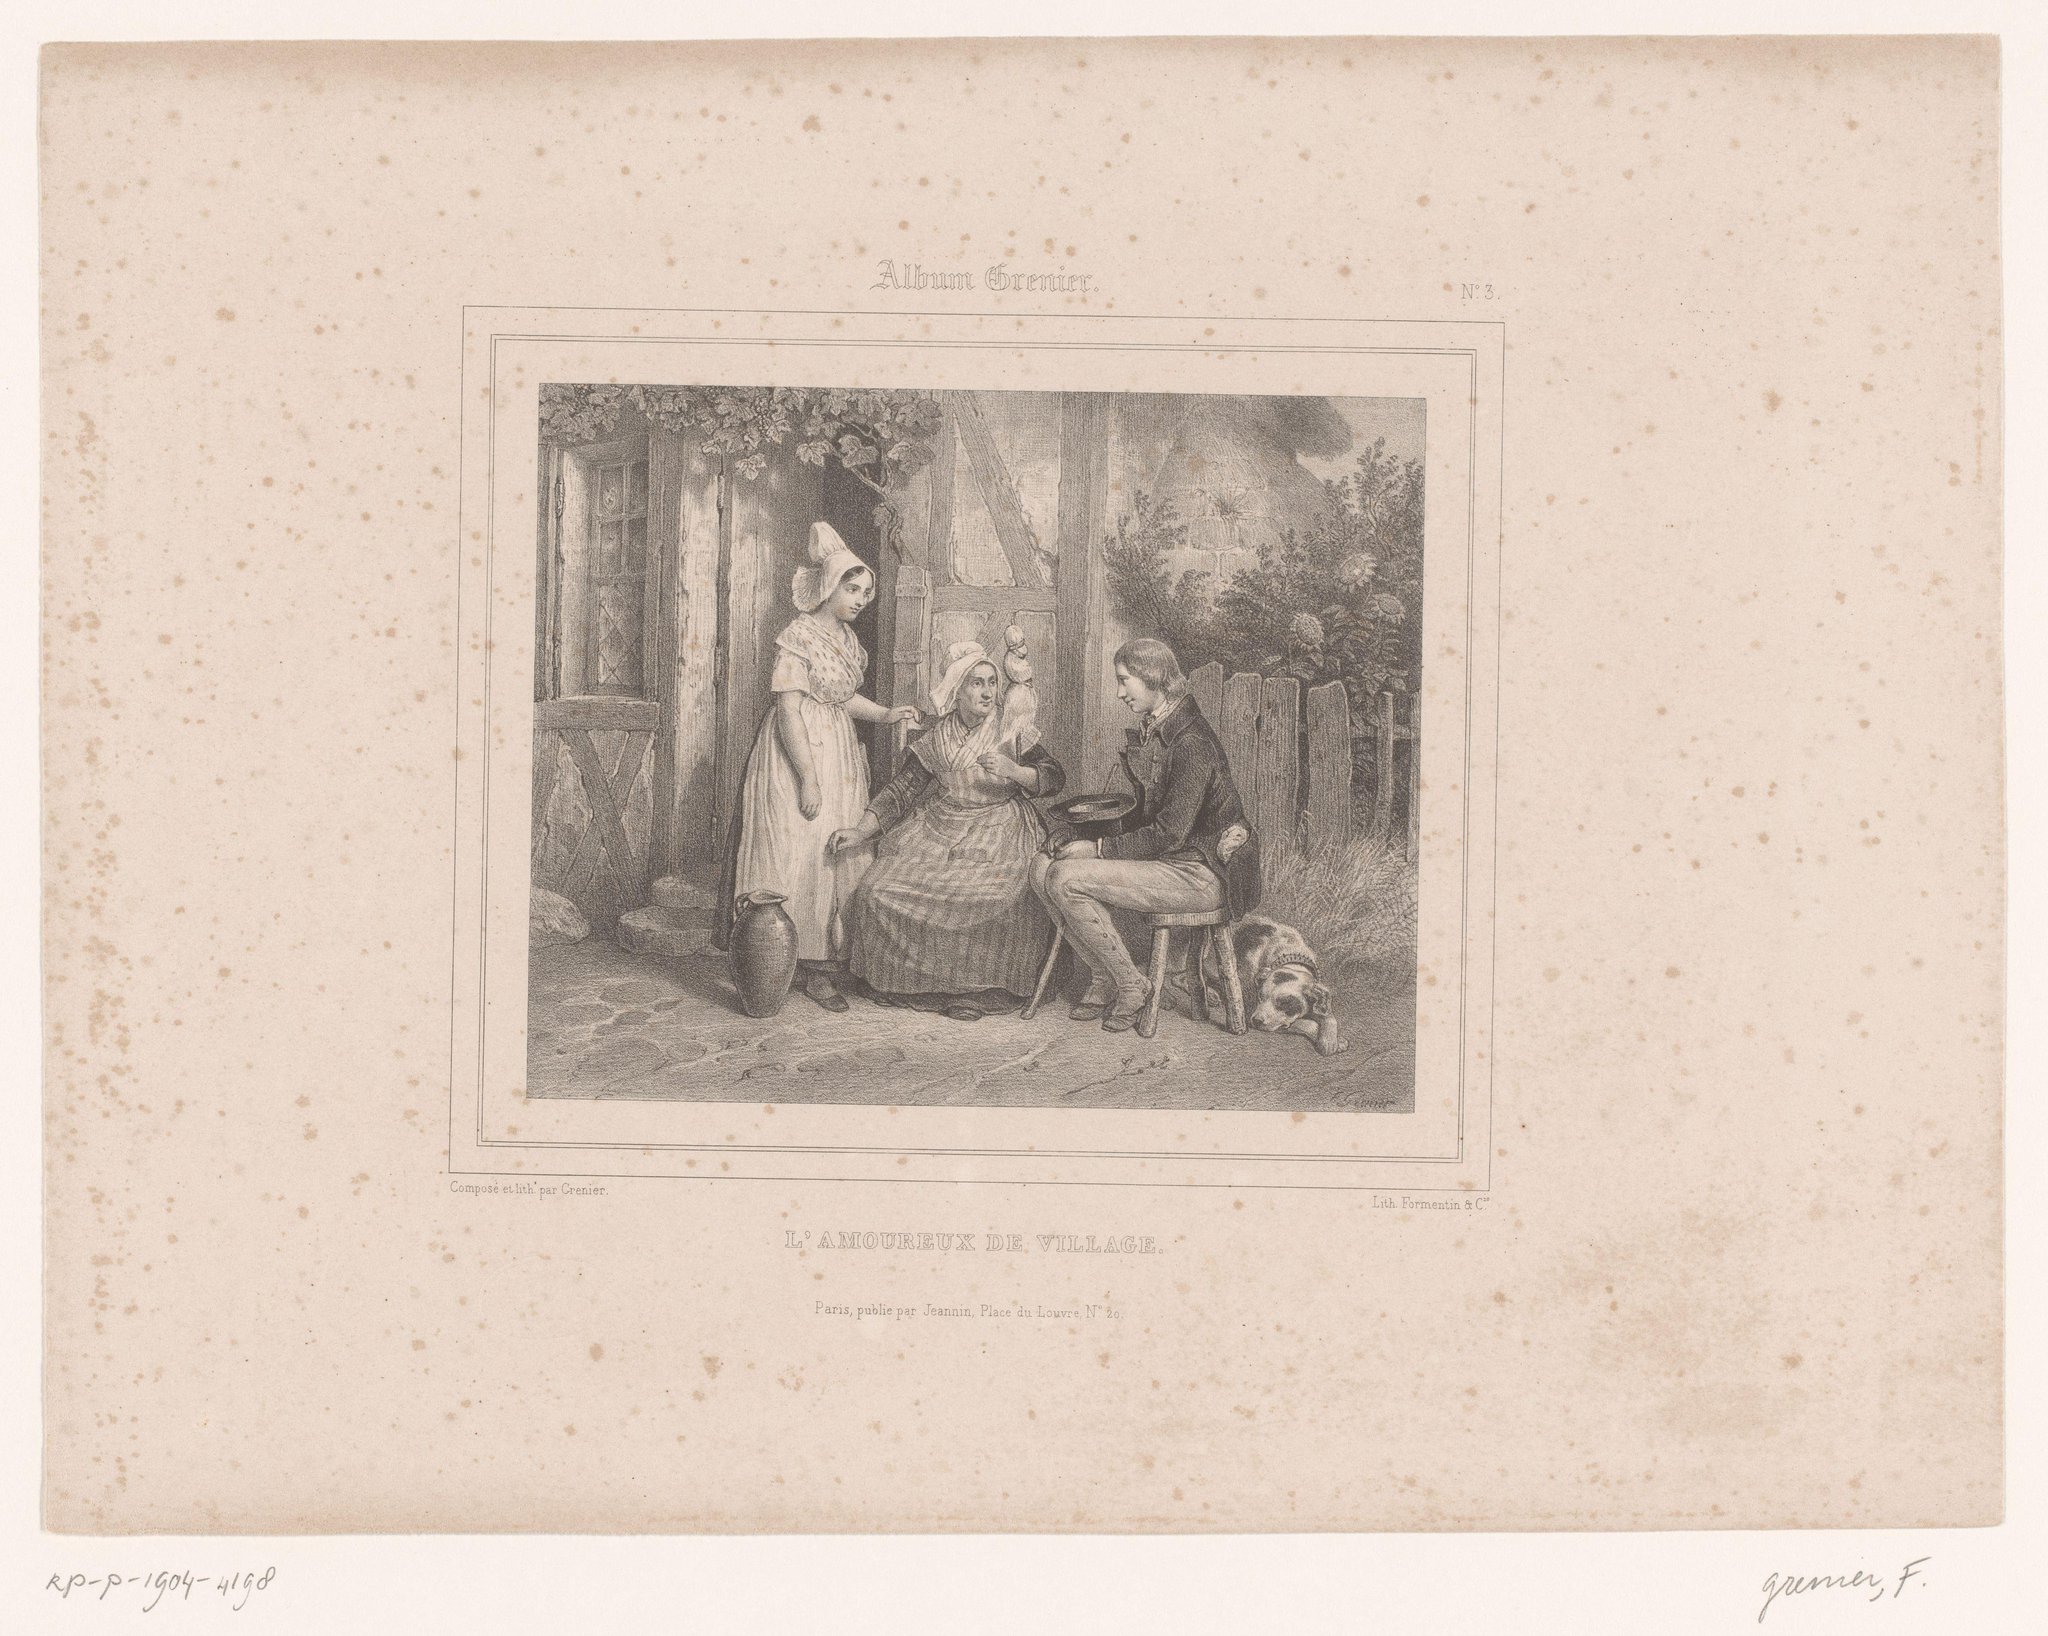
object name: print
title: Twee geliefden en een spinnende vrouw bij een dorpswoning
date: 1829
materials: paper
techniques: lithograph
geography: paris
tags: mother with daughter(s) (mother-love), country dwellers, man presenting his fiancée to his parents - dd - woman presenting her fiancé to her parents, couple of lovers, spinning (manufacture of yarn)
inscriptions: check stamp: Lugt 1397c, collector's mark: Lugt 2228a